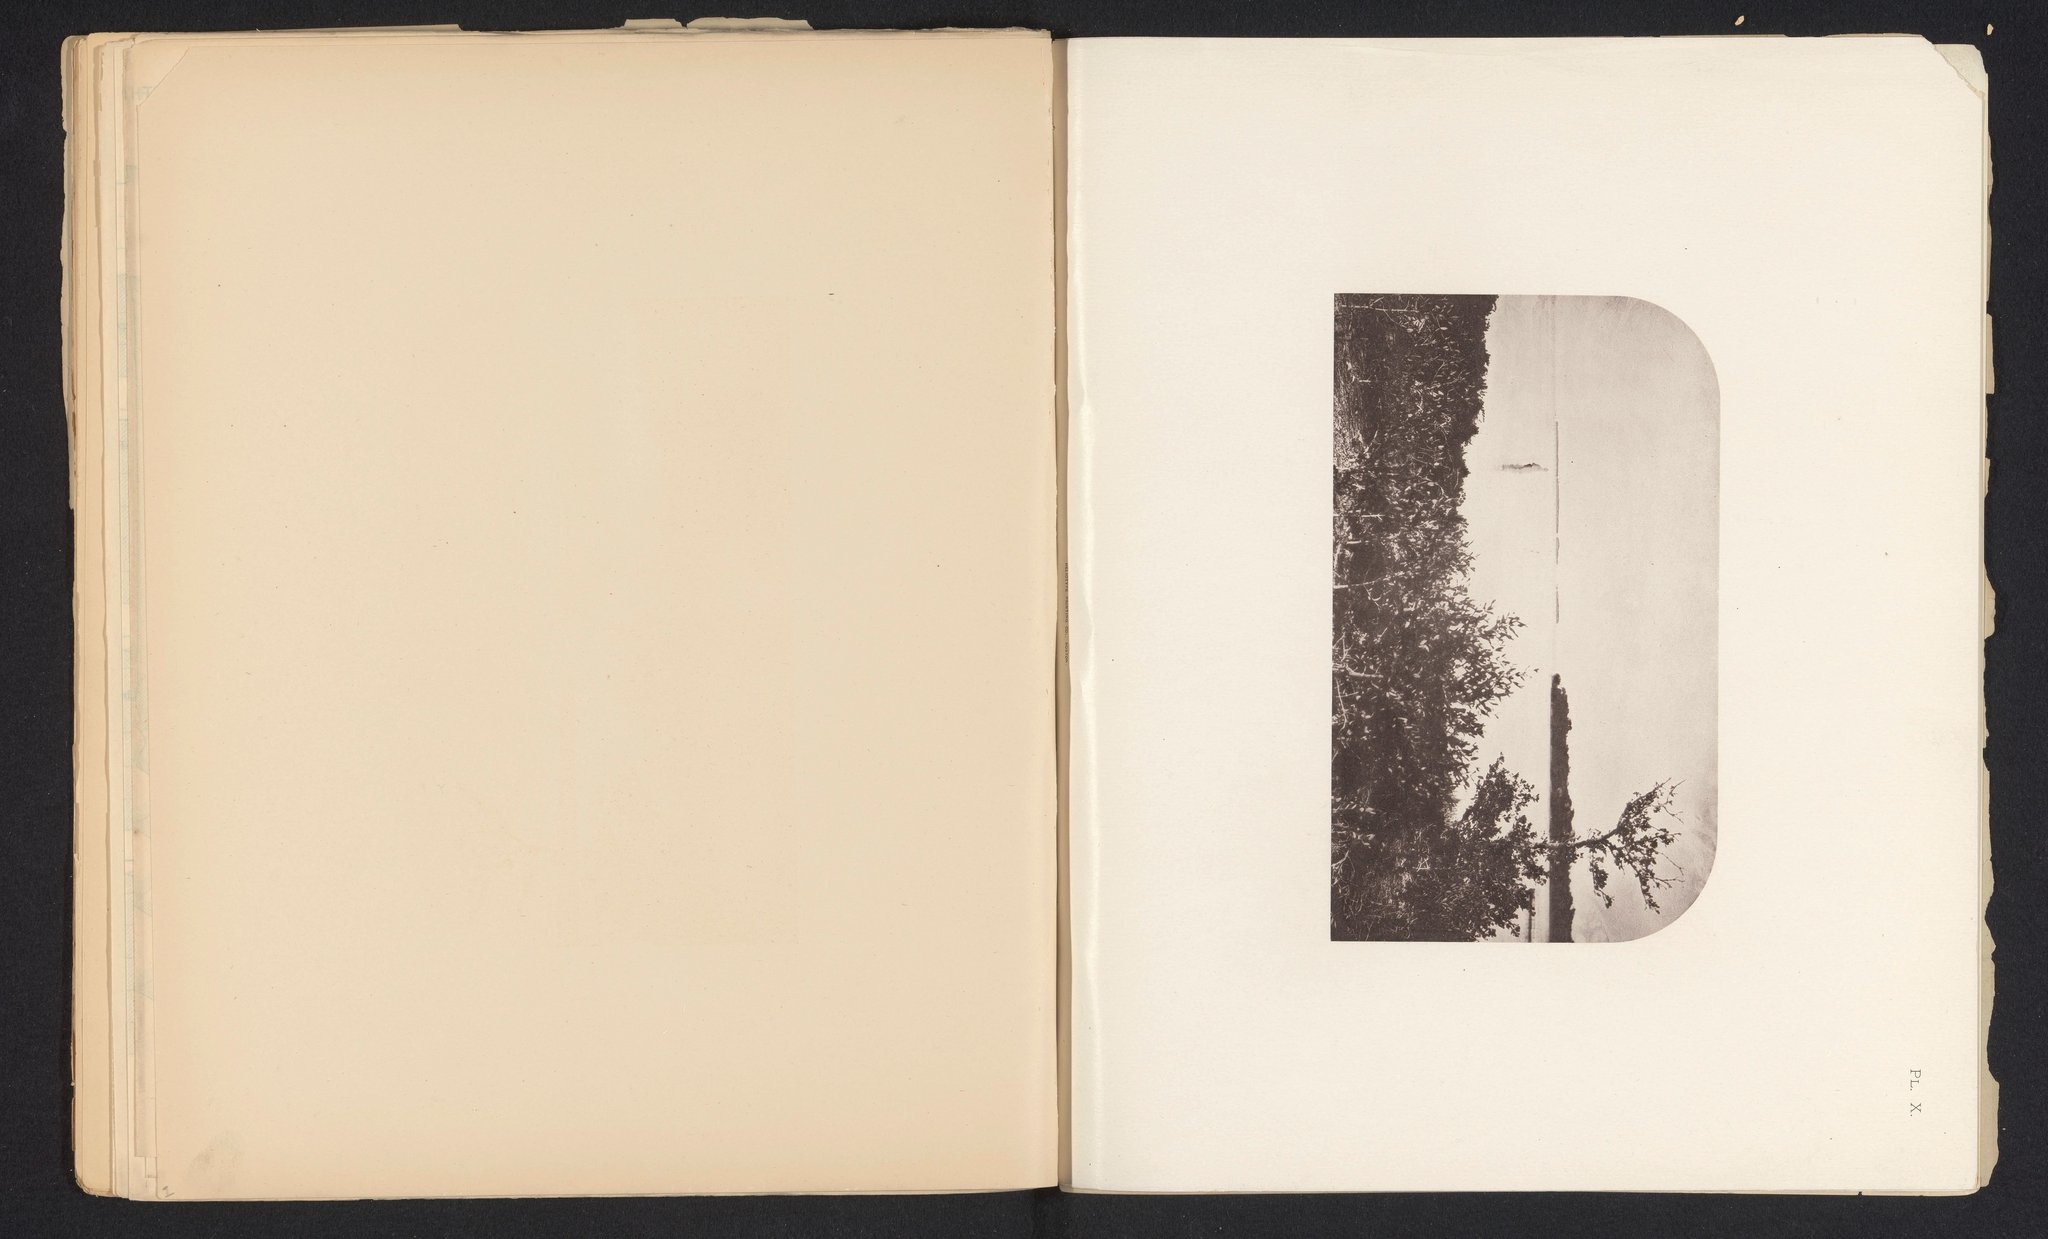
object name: page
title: Gezicht op een eiland van mangroven bij Key West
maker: Anonymous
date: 1875-1885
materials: paper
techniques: photograph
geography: florida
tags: island, trees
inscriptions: number: ‘Pl. X.’